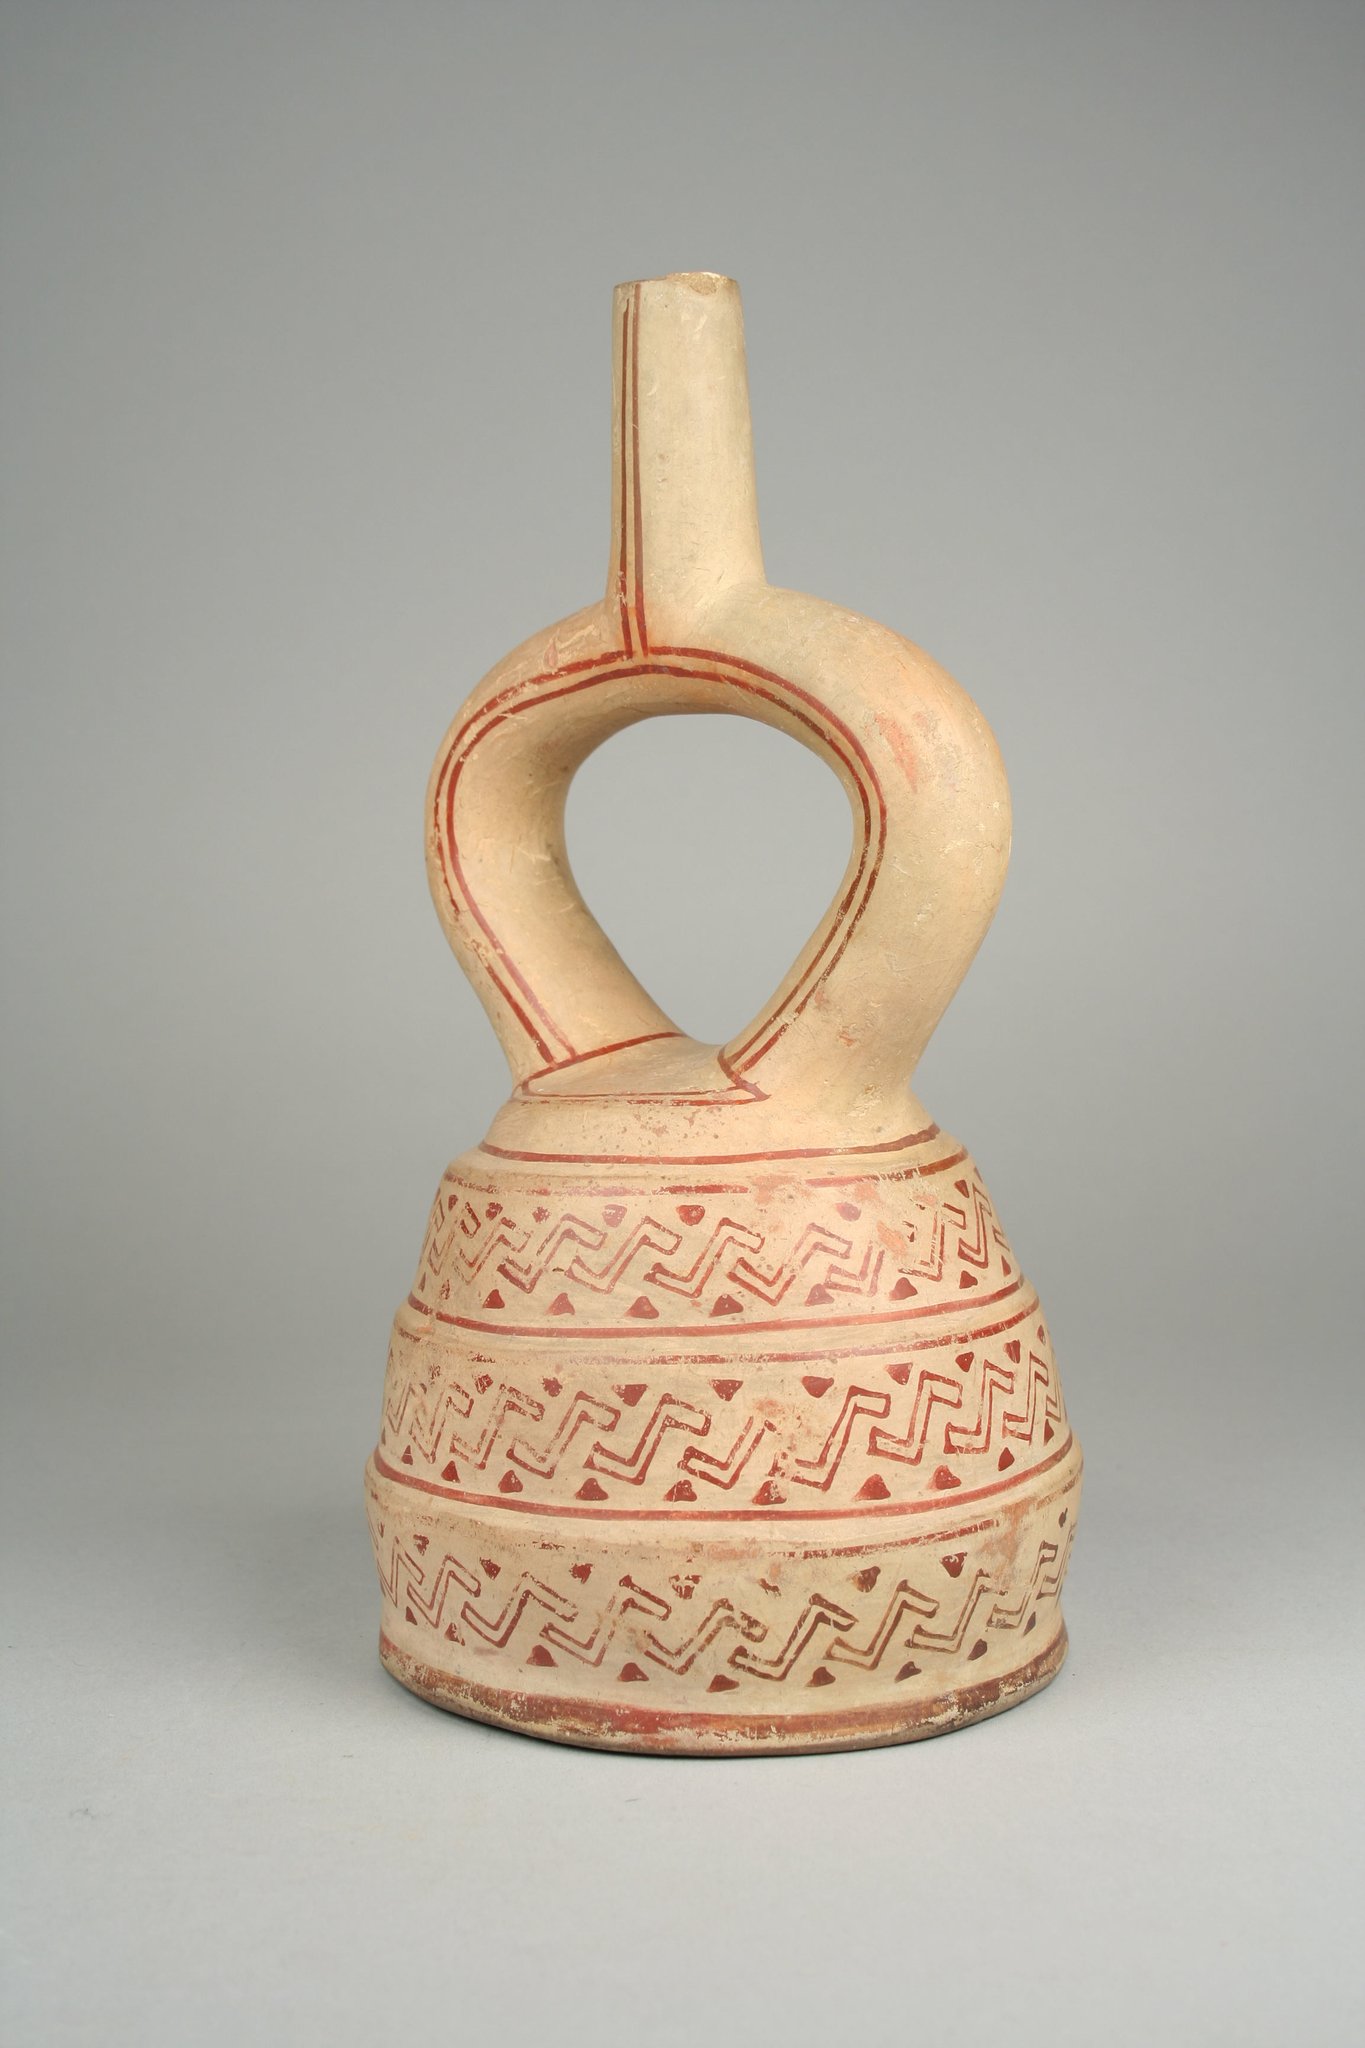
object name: bottle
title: Stirrup Spout Bottle with Three Sections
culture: moche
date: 401-700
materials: ceramic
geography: peru